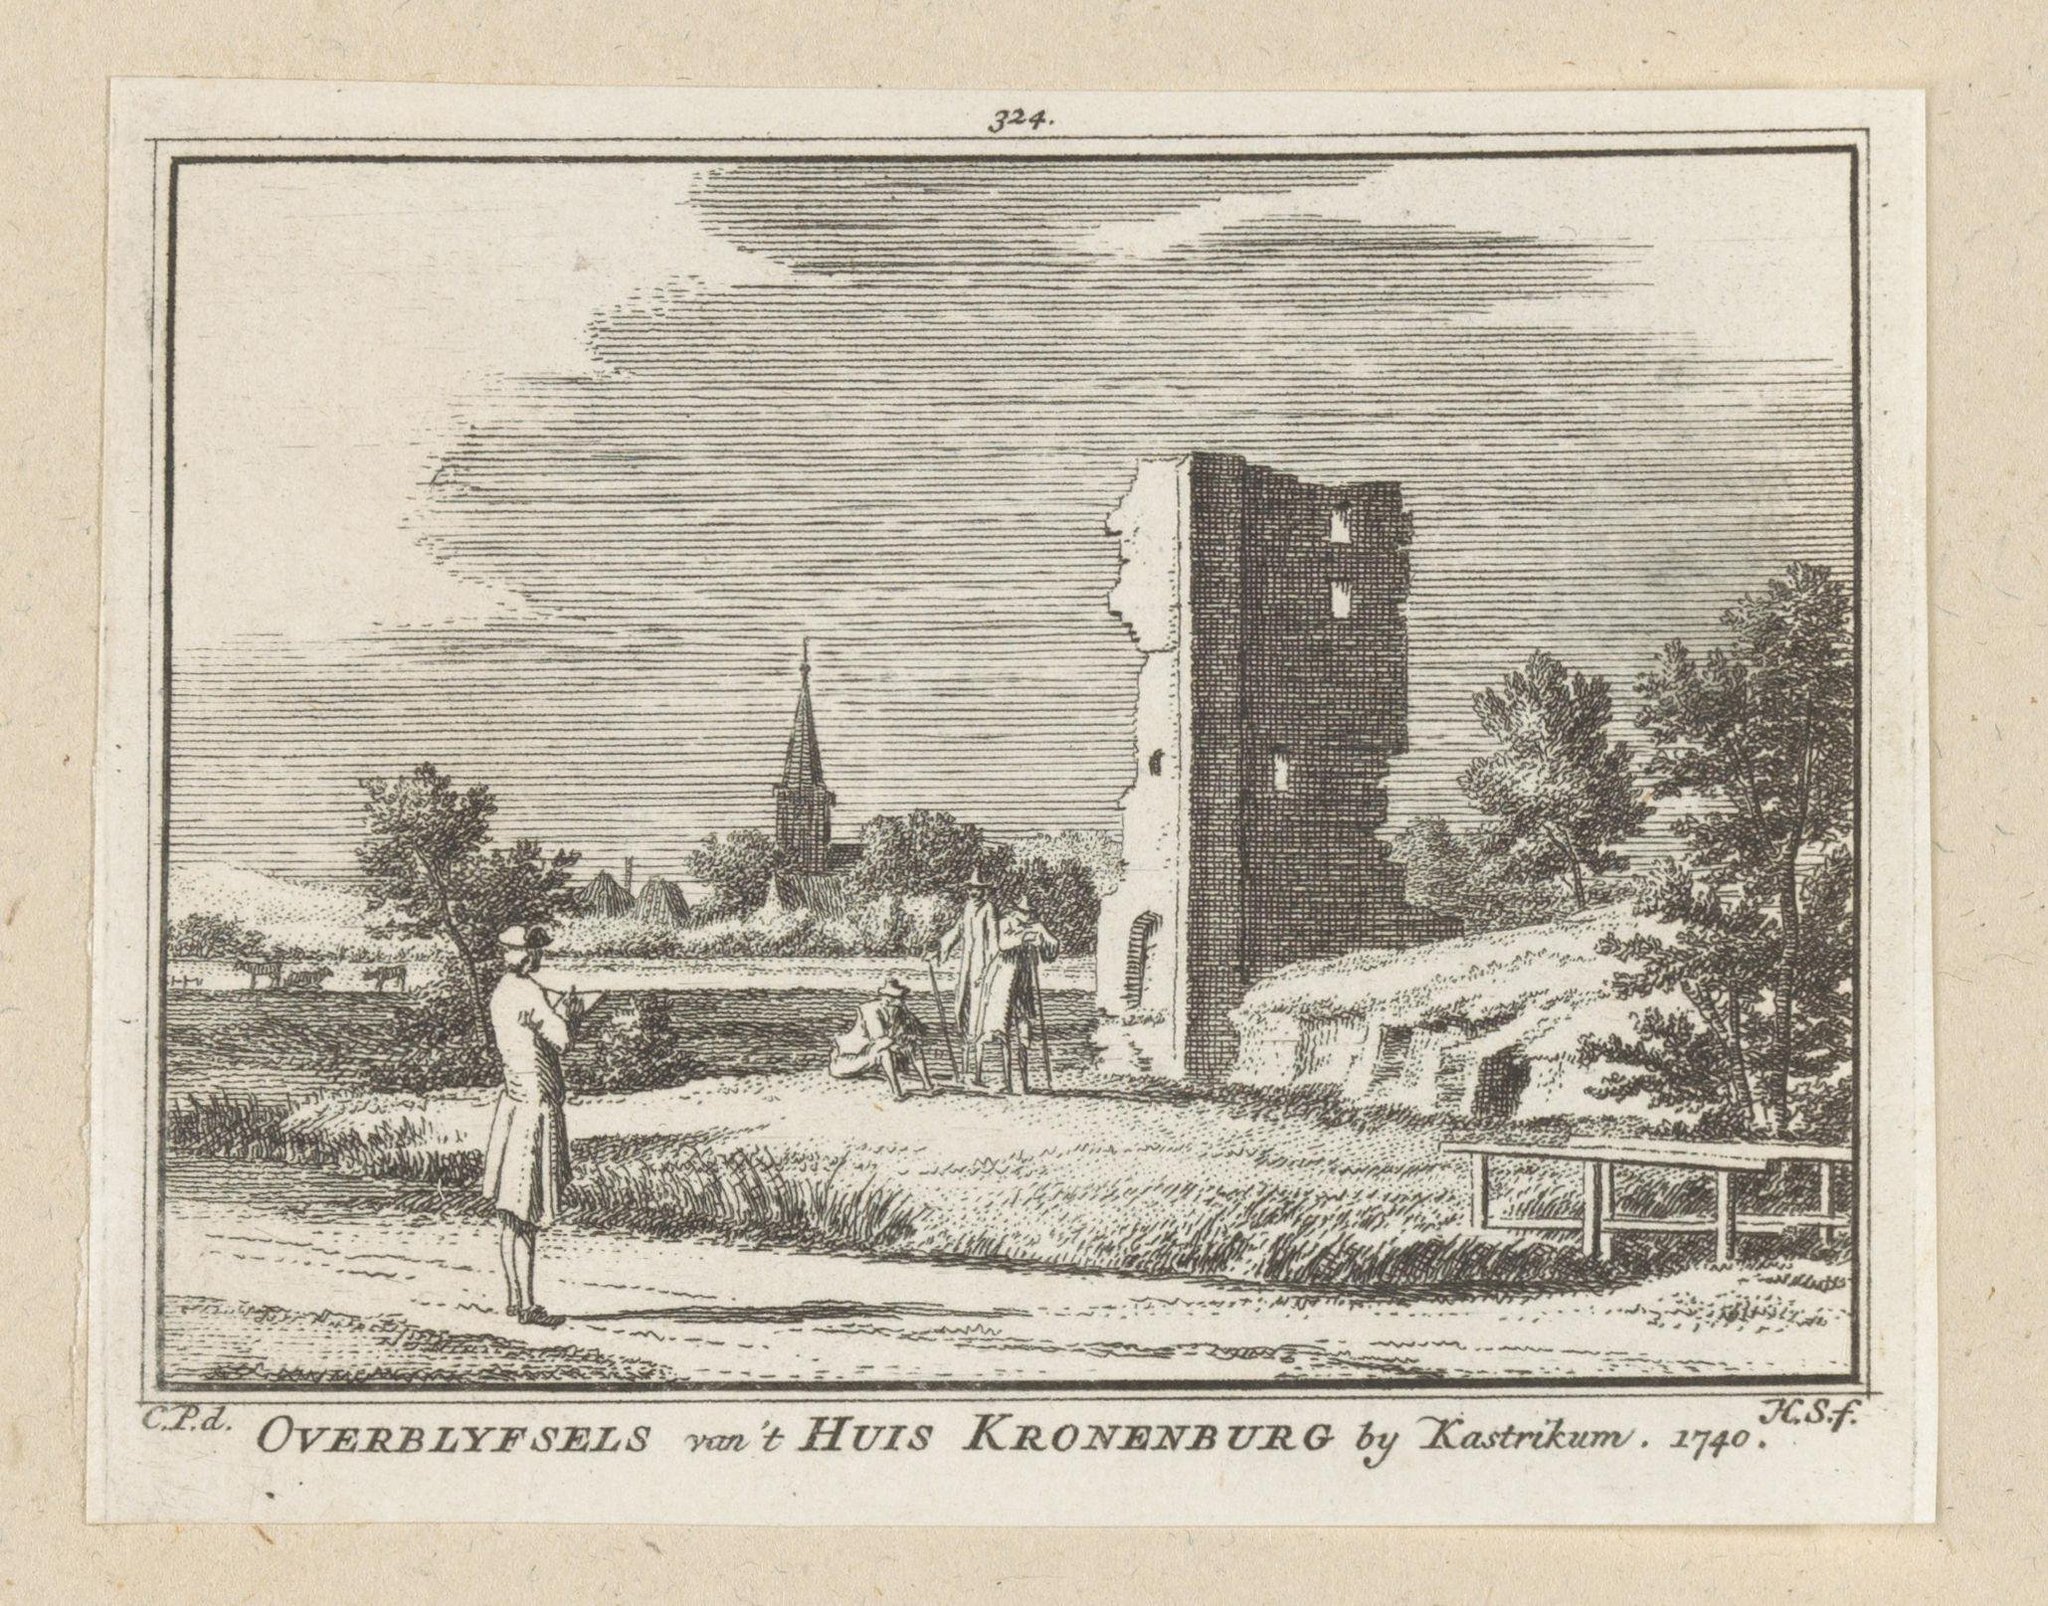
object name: book illustration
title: Gezicht op de ruïne van Huis Kronenburg, 1740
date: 1752-1792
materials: paper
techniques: engraving, etching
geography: haarlem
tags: church (exterior), ruin of a dwelling, house, castle, etc.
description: Prent ook gebruikt in: Het verheerlykt Nederland of kabinet van hedendaagsche gezigten van steden, dorpen (…). 9 delen. Amsterdam: Isaak Tirion en weduwe Isaak Tirion, 1745-1774, dl. 4 (1752), ill. 324. Of in: Nederlandsche tafereelen; of eene keurige verzameling van negen honderd fraaije gezigten van steden, dorpen, sloten, oudheden (….). 9 delen. Amsterdam: Jan de Groot, 1792, dl. 4, ill. 324. Uit welke druk het huidige exemplaar precies komt is niet na te gaan.